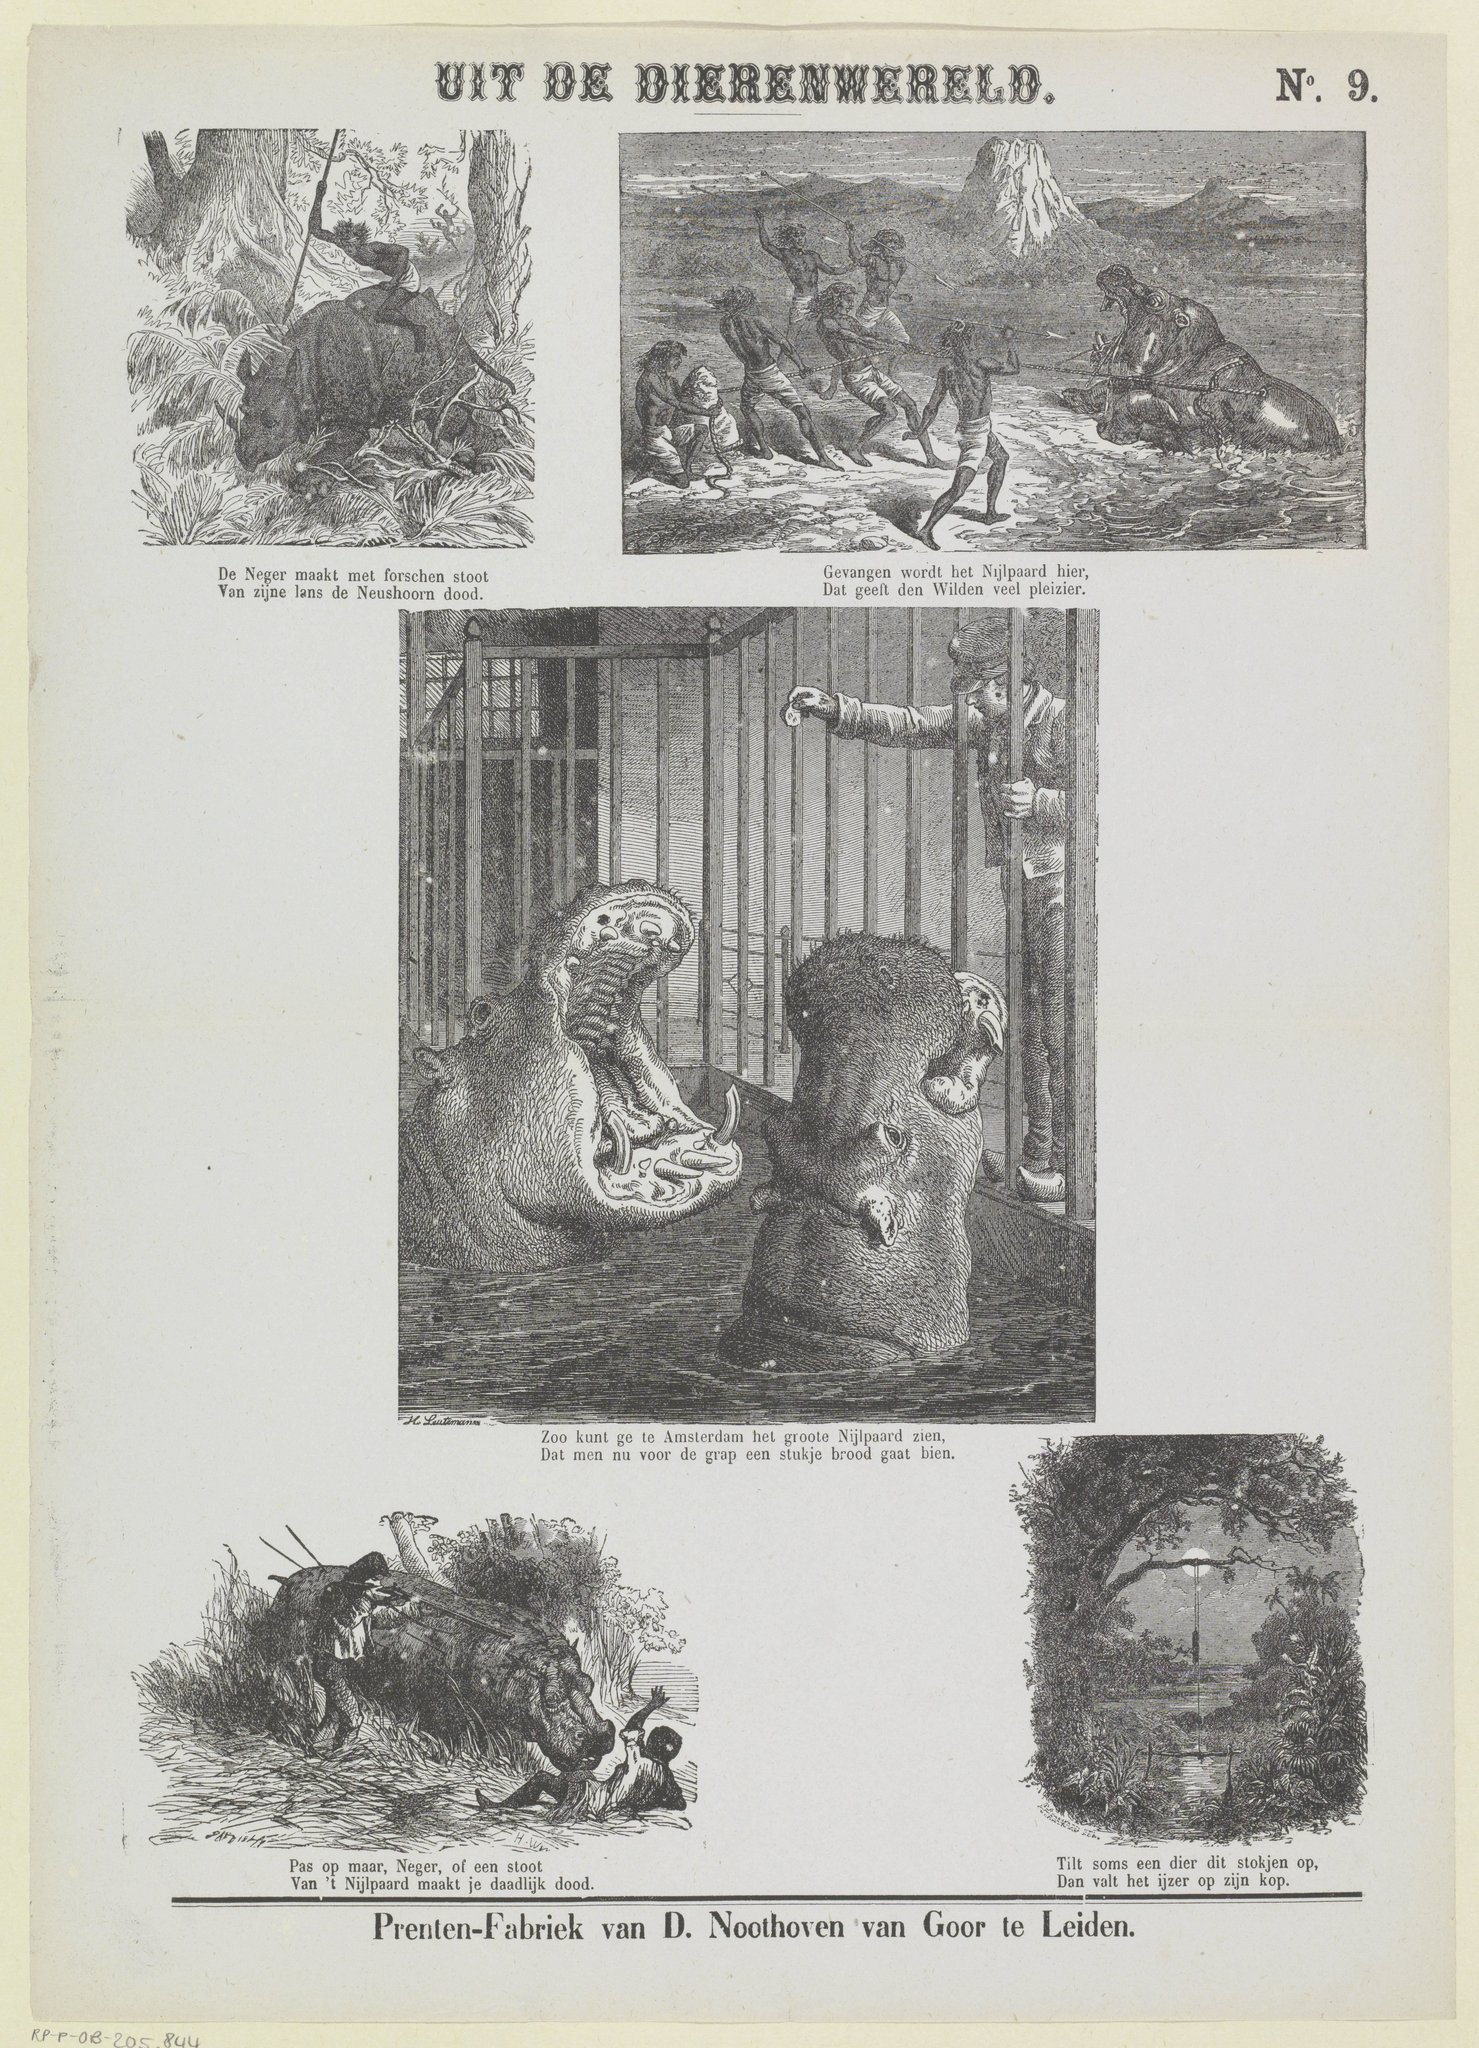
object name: print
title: Uit de dierenwereld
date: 1850-1881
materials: paper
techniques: letterpress printing, engraving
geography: leiden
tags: hoofed animals: hippopotamus, hoofed animals: rhinoceros, hunt ~ mammals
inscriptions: collector's mark: Lugt 2760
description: Blad met 5 voorstellingen van neushoorns en nijlpaarden waar op wordt gejaagd en die in gevangenschap leven. Onder elke voorstelling een tweeregelig vers. Genummerd rechtsboven: No. 9.